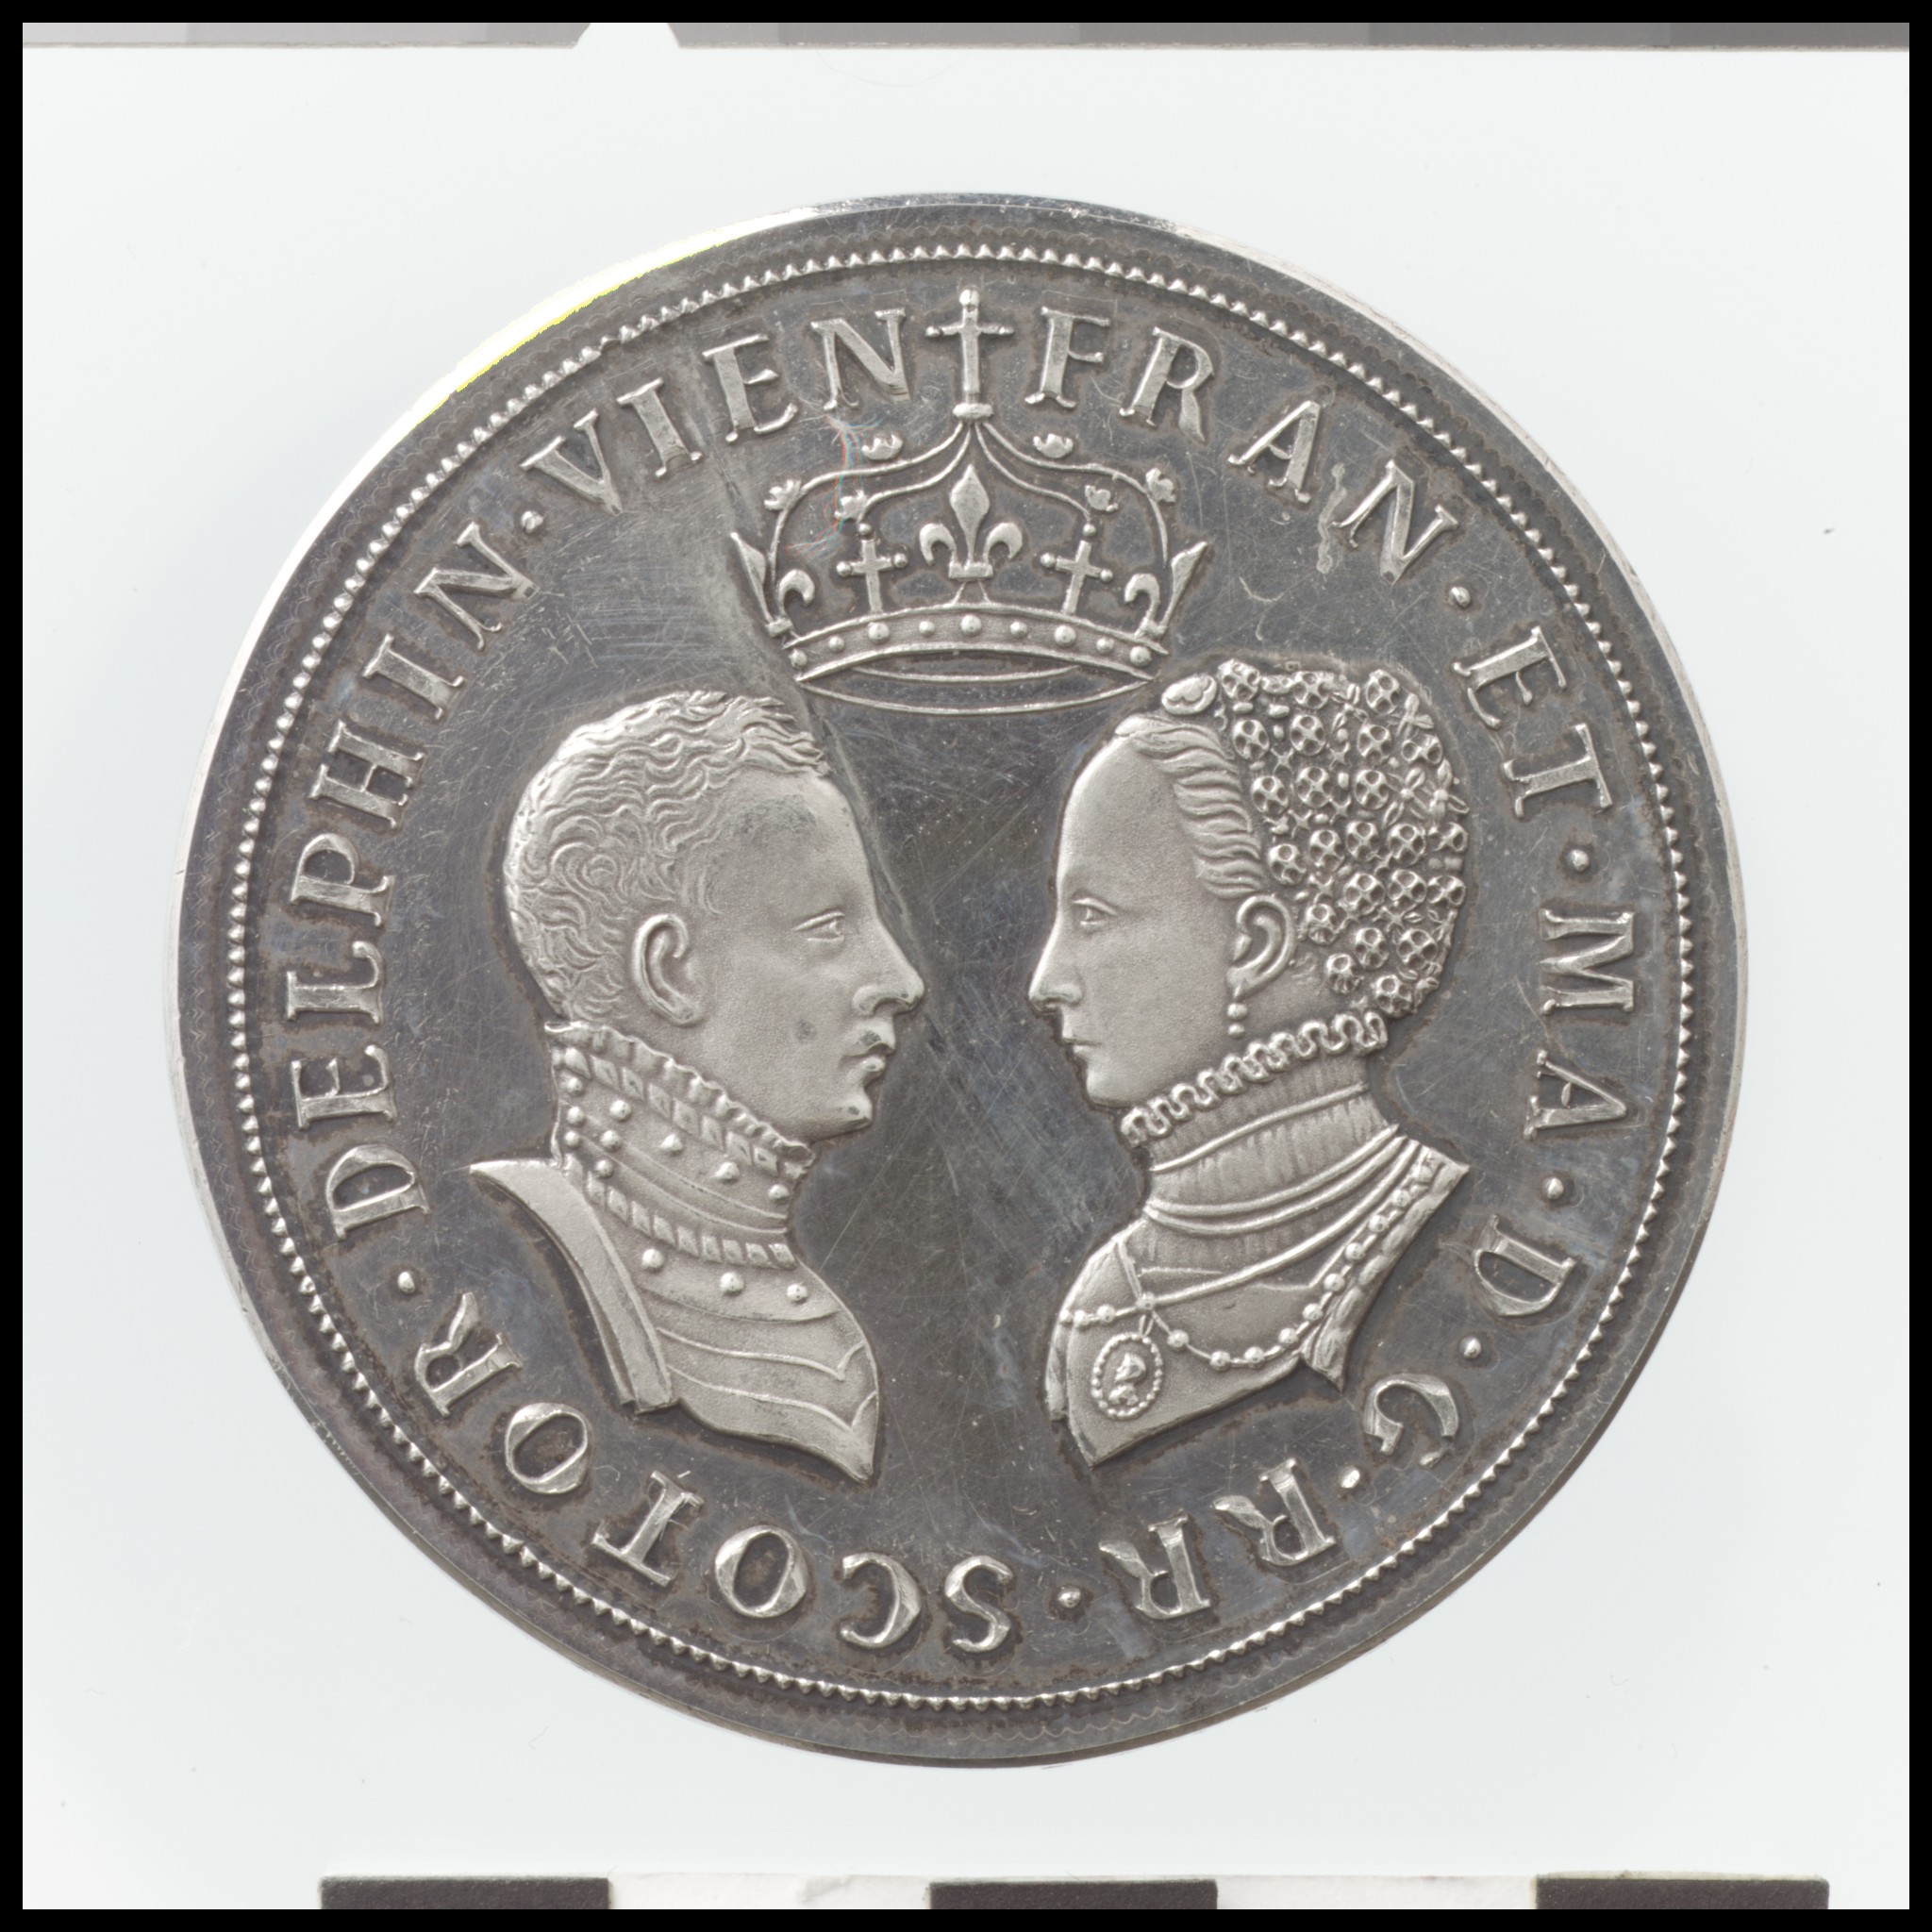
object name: medal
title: Marriage of Mary, Queen of Scots (1558)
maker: jean-baptiste salmson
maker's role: maker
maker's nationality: french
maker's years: 1807-1866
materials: silver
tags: men,profiles,coat of arms